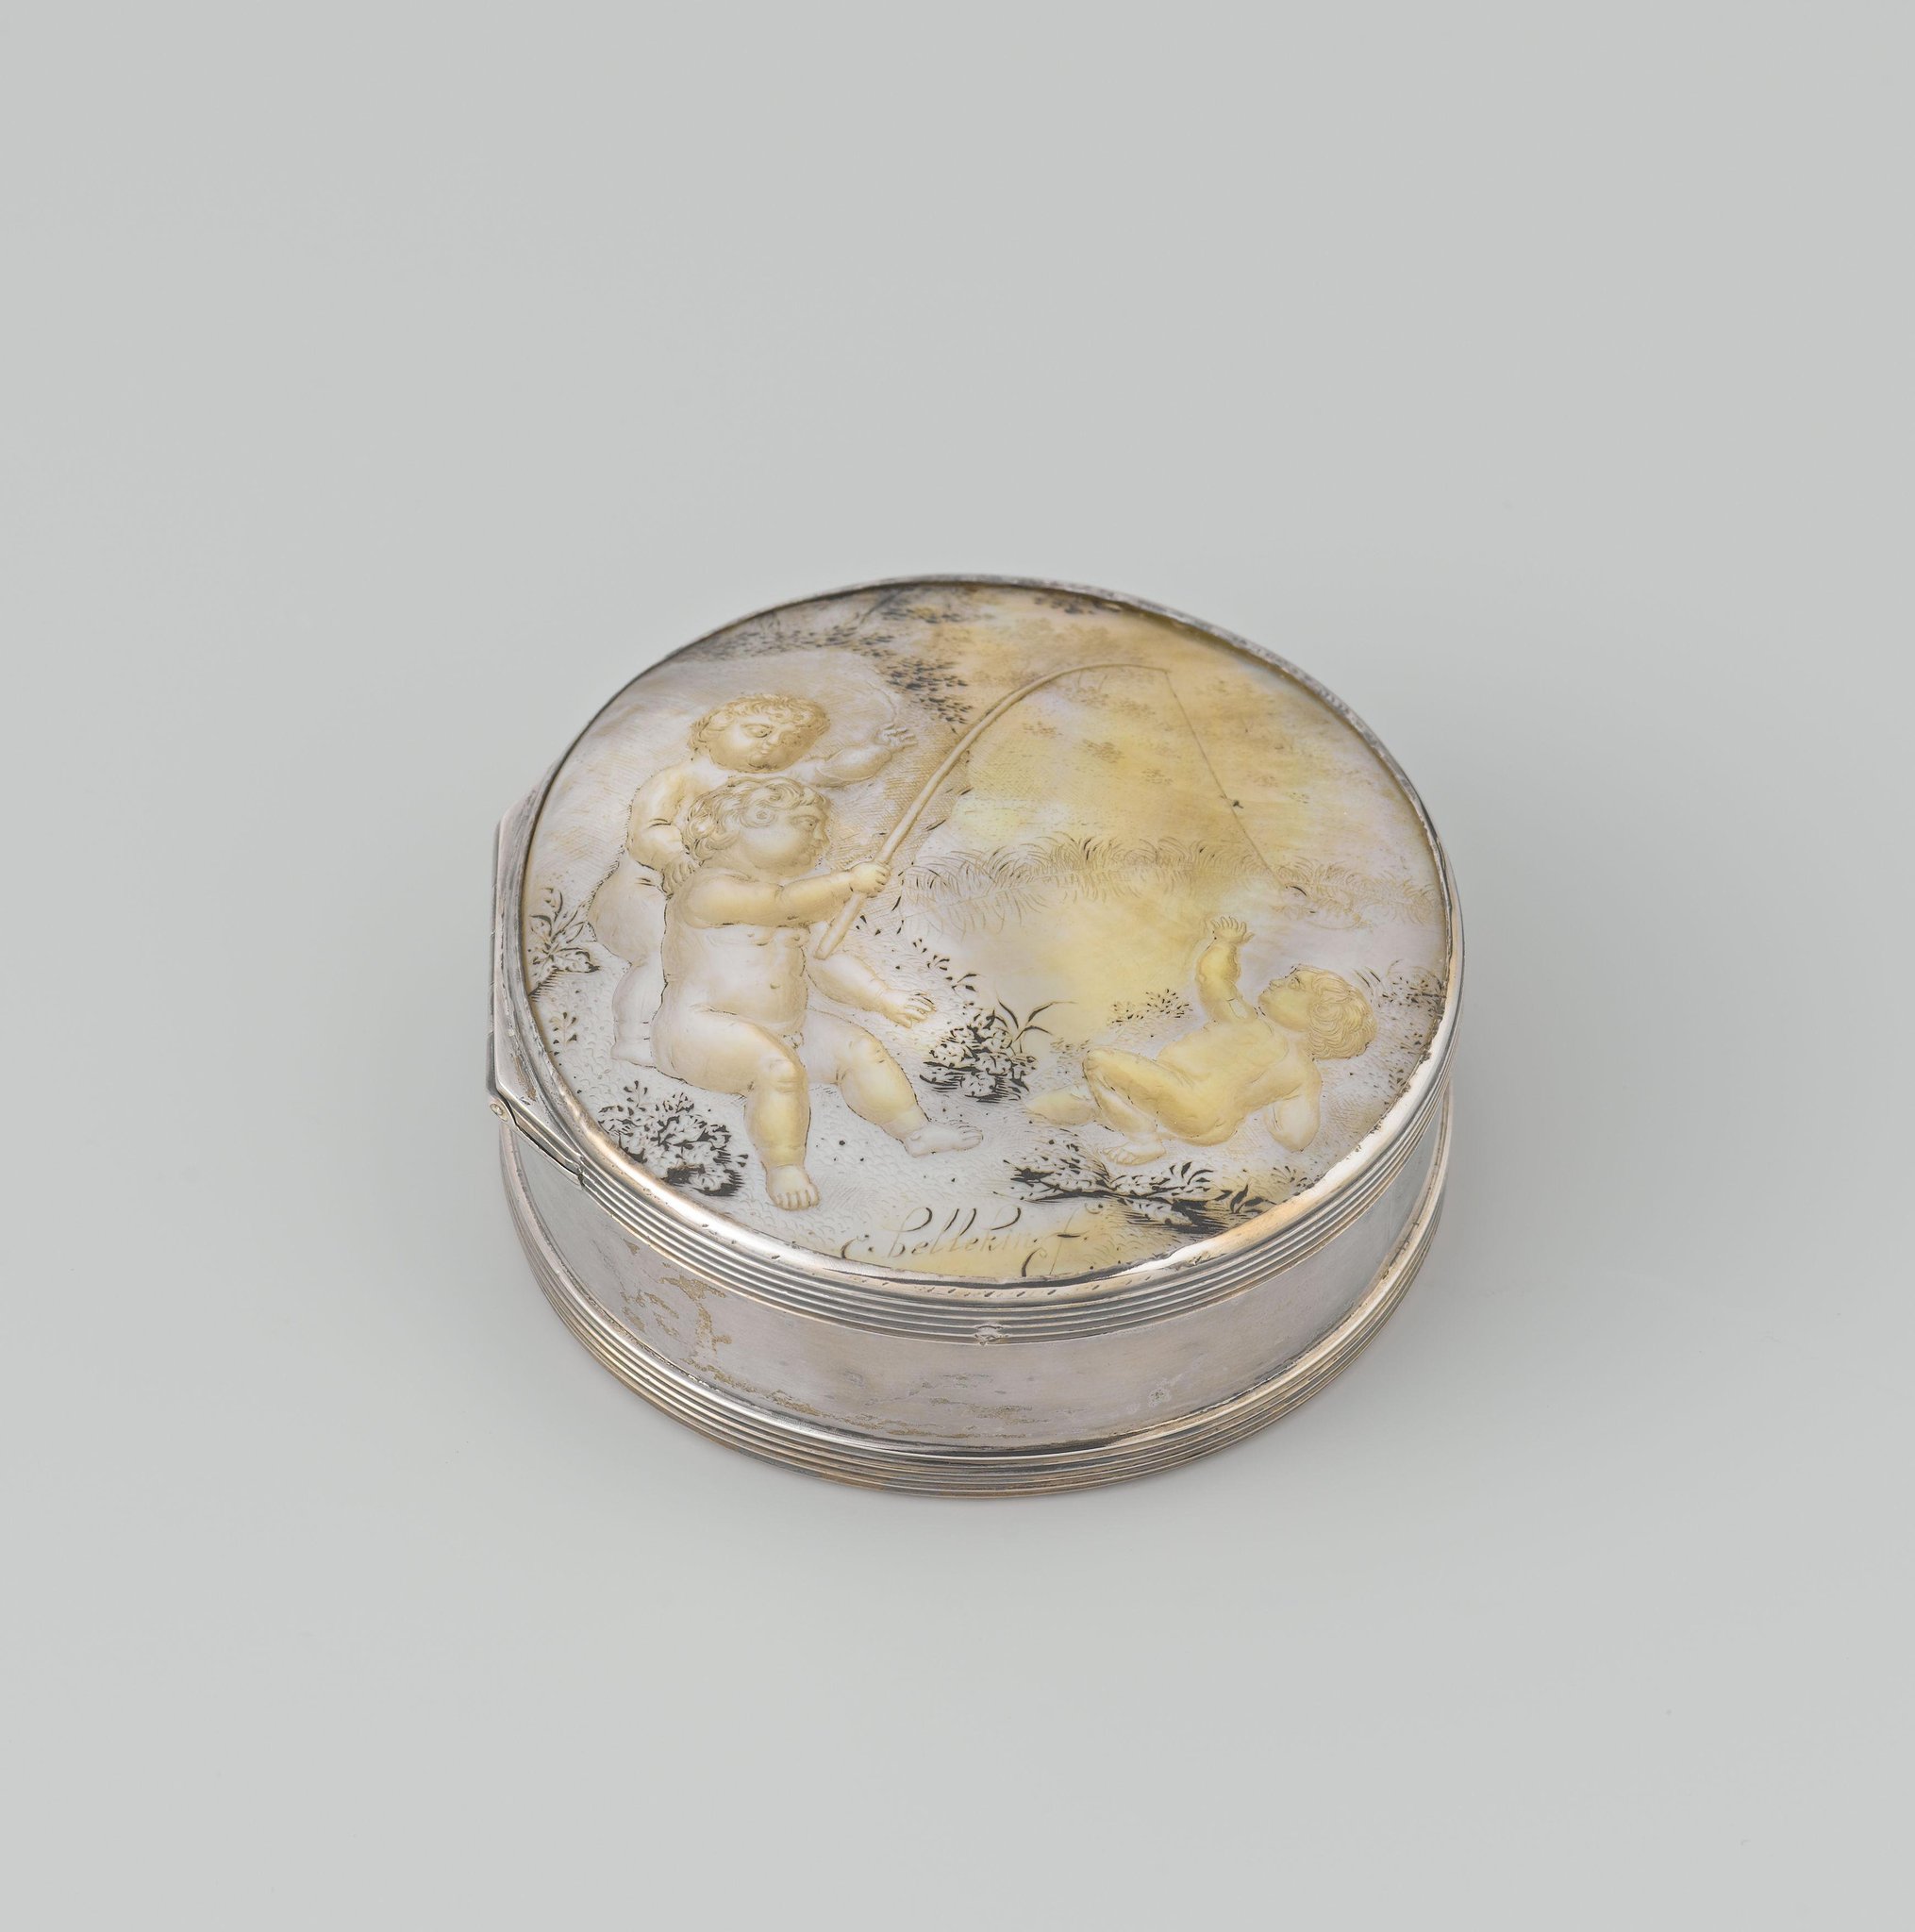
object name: snuffbox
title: Snuffbox with relief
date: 1660-1700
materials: mother of pearl, silver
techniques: engraving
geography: amsterdam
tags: cupids: 'amores', 'amoretti', 'putti'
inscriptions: signature, on the bottom of the relief, engraved: ‘C. bellekin. f.’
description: Snuifdoos van zilver met een parelmoeren deksel, waarop in gravure en reliëf snijwerk de voorstelling van drie amoretten. Tegen een heuvelachtige achtergrond, begroeid met bomen zit aan een plas links een jongetje met een hengel in de rechterhand. Achter hem staat een kind, dat zijn rechterhand op zijn schouder heeft gelegd. Rechts op de voorgrond ligt een derde kind, dat zijn linkerhand opsteekt. Een vis heeft zojuist toegehapt. Op de voorgrond planten, op de achtergrond bomen; het water wordt omzoomd door riet.